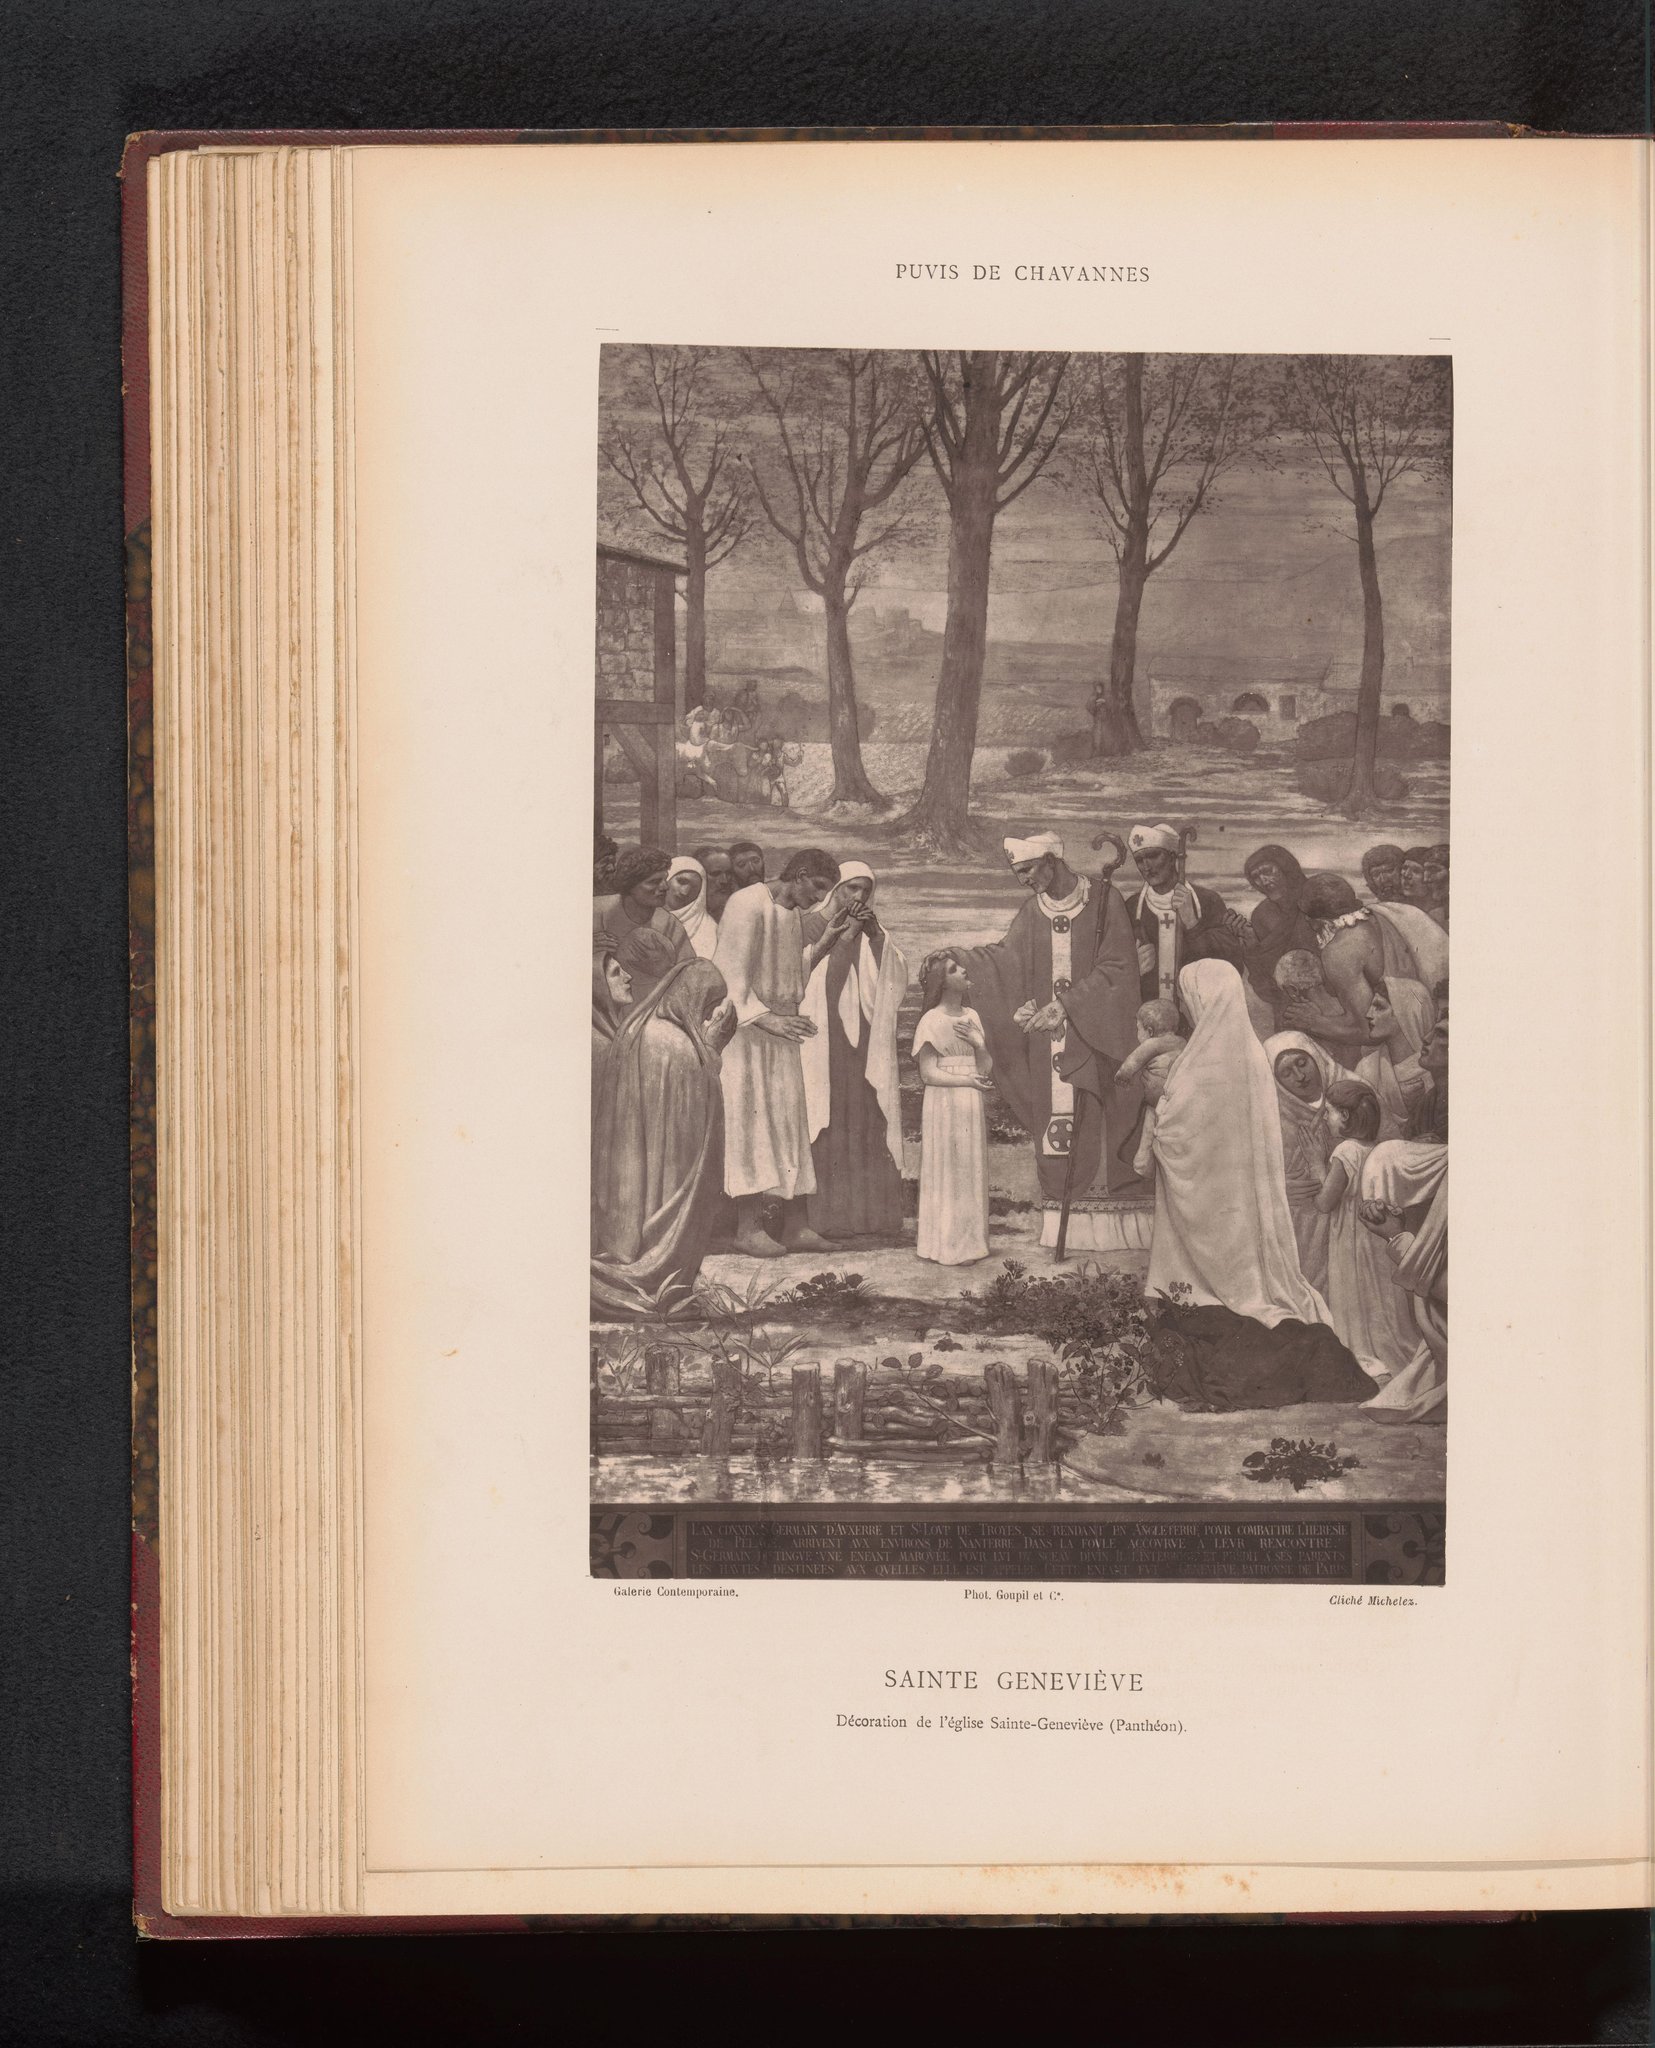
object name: reproduction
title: Reproductie van Sainte Geneviève door Pierre Puvis de Chavannes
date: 1873-1878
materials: paper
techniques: woodburytype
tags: painting, drawing and the graphic arts, the virgin genevieve (genofeva, genovefa); possible attributes: angel, book, candle (or taper), crown, crook, demon, distaff, medallion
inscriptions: inscription: ‘Puvis de Chavannes/ Galerie Contemporaine’